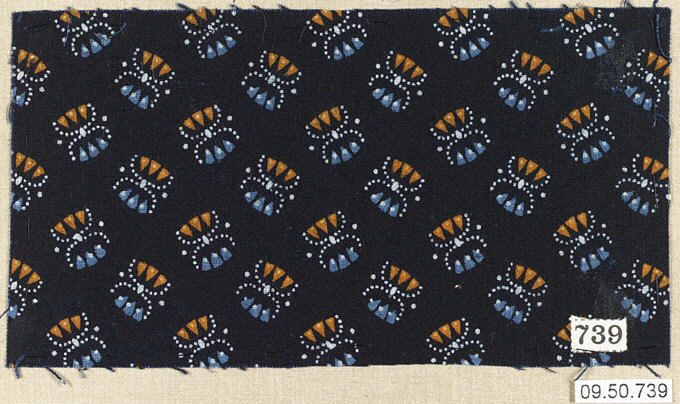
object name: piece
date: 1801-1900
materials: cotton